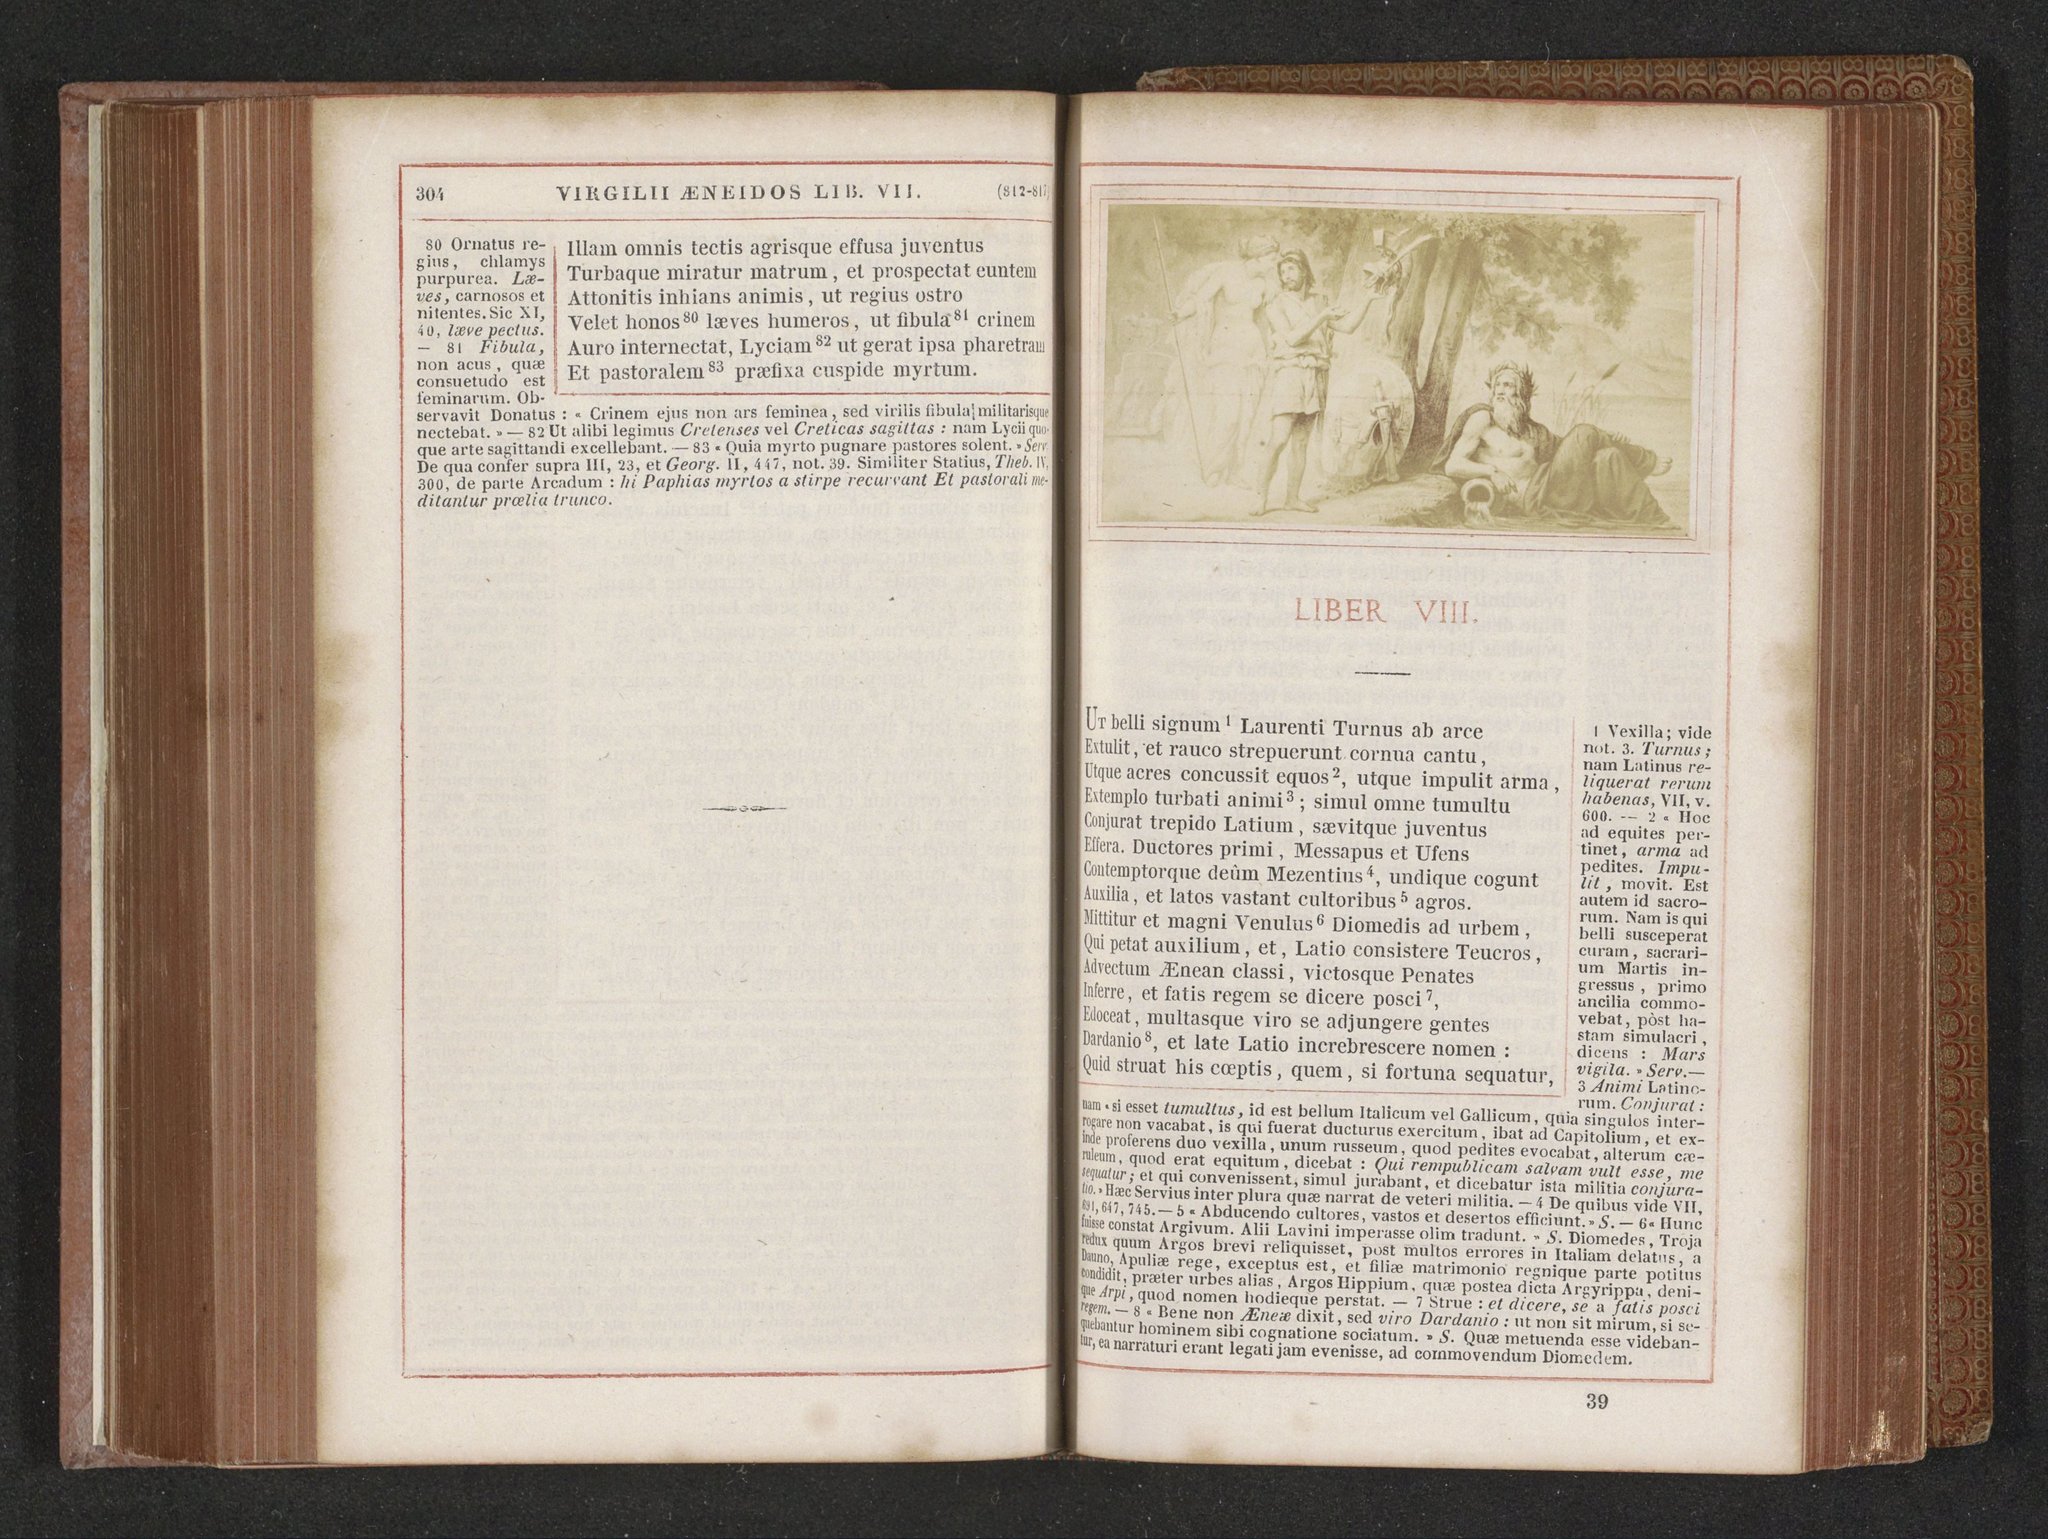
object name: page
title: Fotoreproductie van een schilderij, voorstellende Aeneas ontvangt nieuwe wapens van Venus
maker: Anonymous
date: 1850-1858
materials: photographic support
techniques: albumen print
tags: venus hands over the armour to aeneas